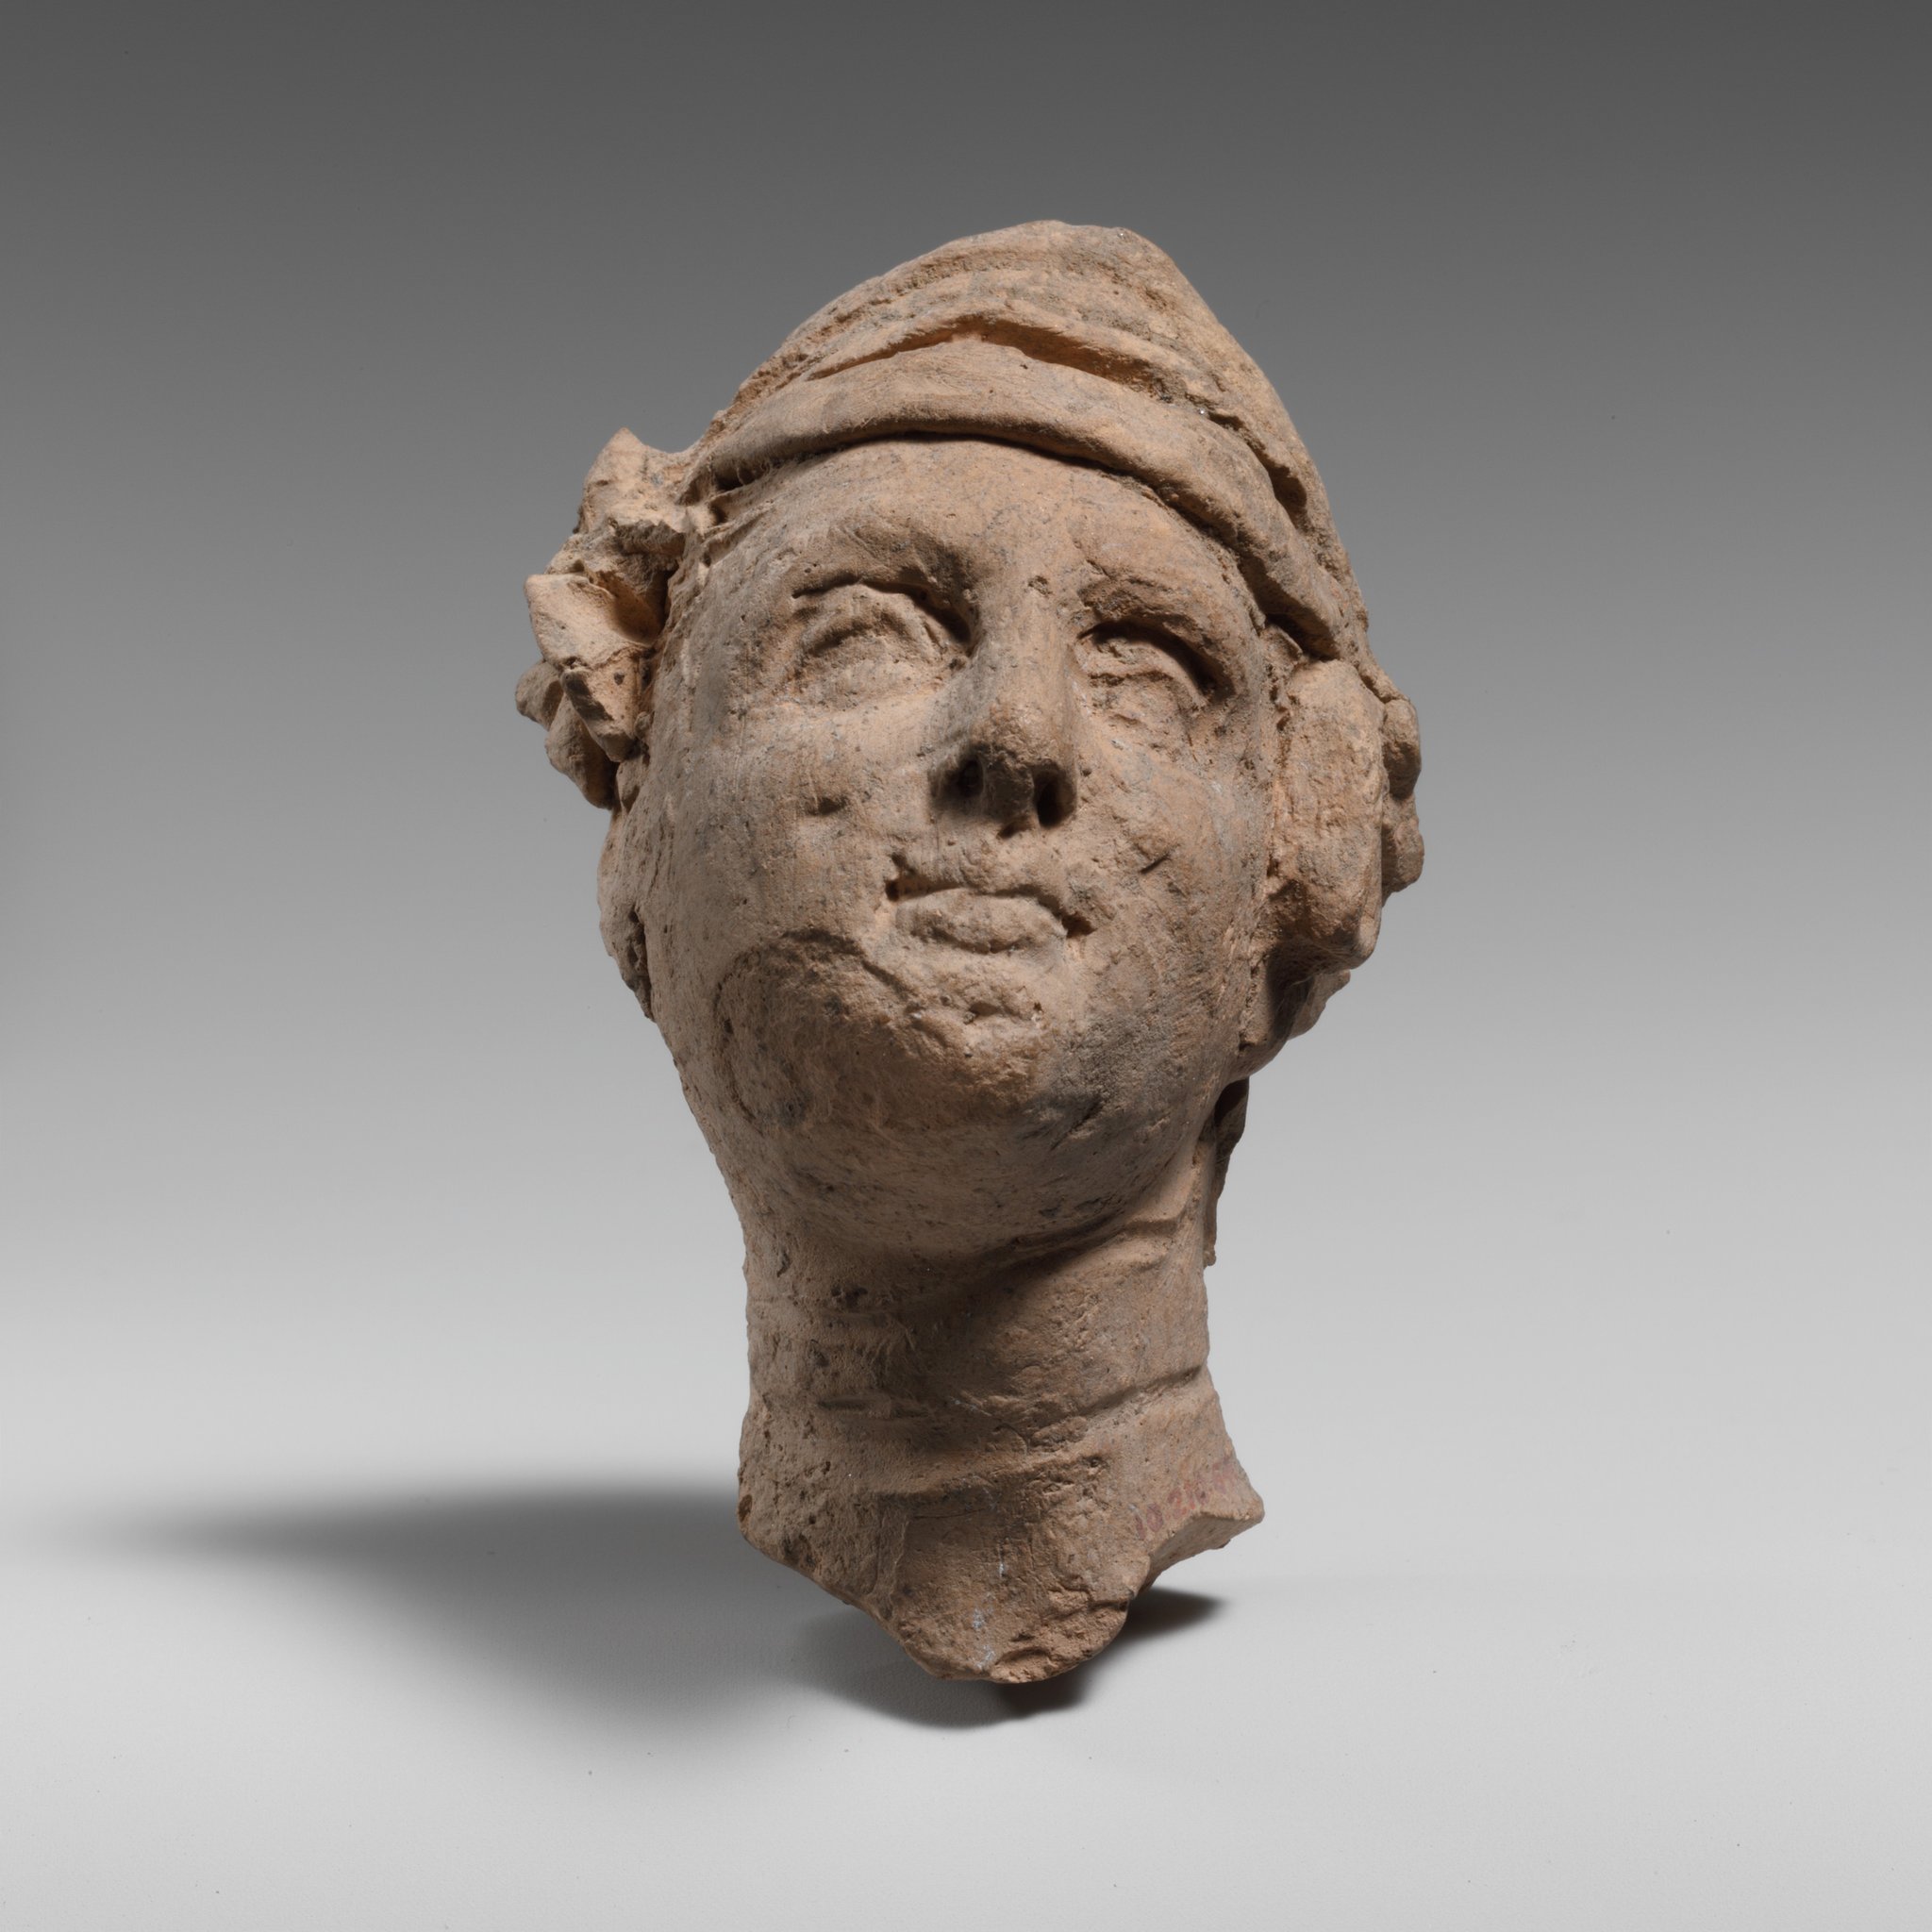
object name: head of a woman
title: Terracotta head of a woman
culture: greek, south italian, tarentine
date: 400-301 BCE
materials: terracotta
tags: heads,women